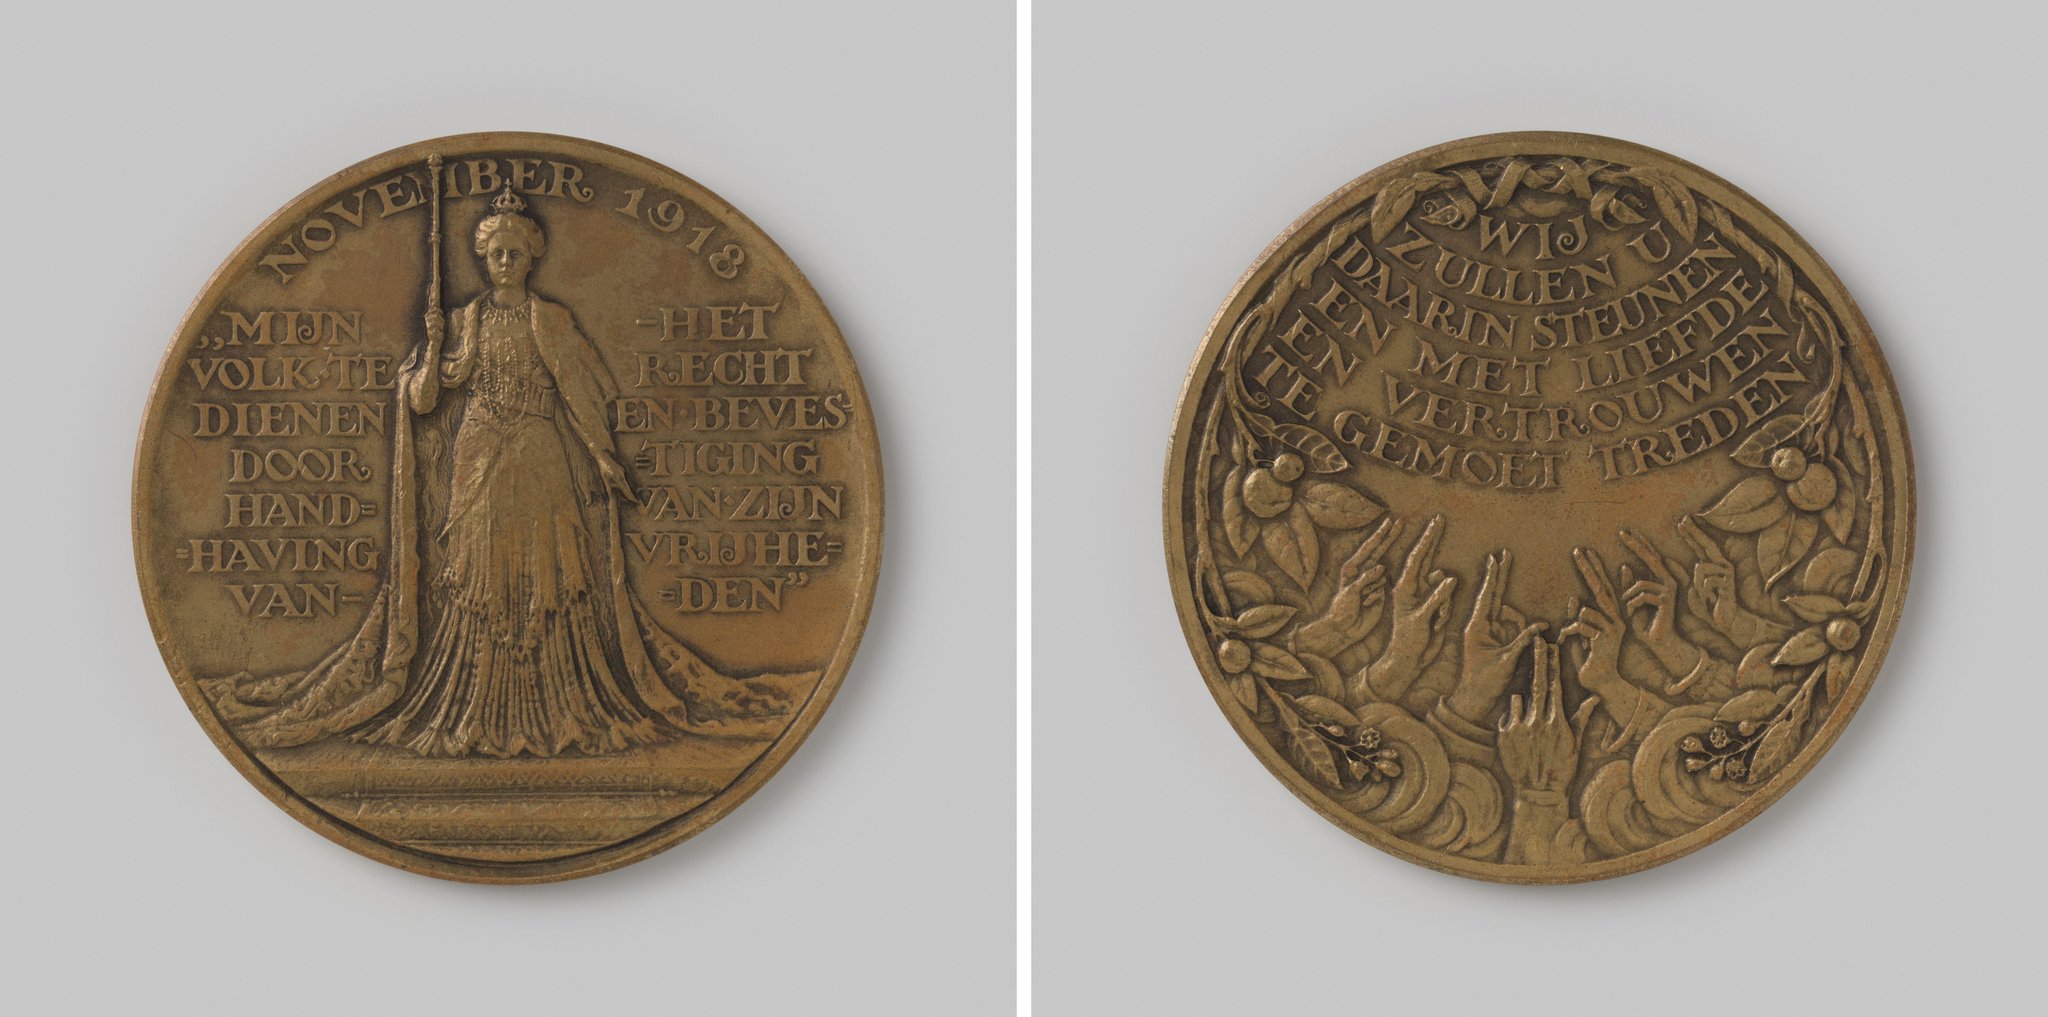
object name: history medal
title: Voor Koningin en tegen revolutie 1918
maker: johannes cornelis wienecke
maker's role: medailleur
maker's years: 1872-1945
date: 1918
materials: bronze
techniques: striking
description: Bronzen penning, op de voorzijde Koningin Wilhelmina staand op een podium in koningsmantel, met geheven scepter, met bovenaan omschrift en in het veld links en rechts tekst, op de keerzijde opgeheven handen met zwerende vingers onder zes gebogen tekstregels, tussen twee samengebonden afhangende oranjetakken.